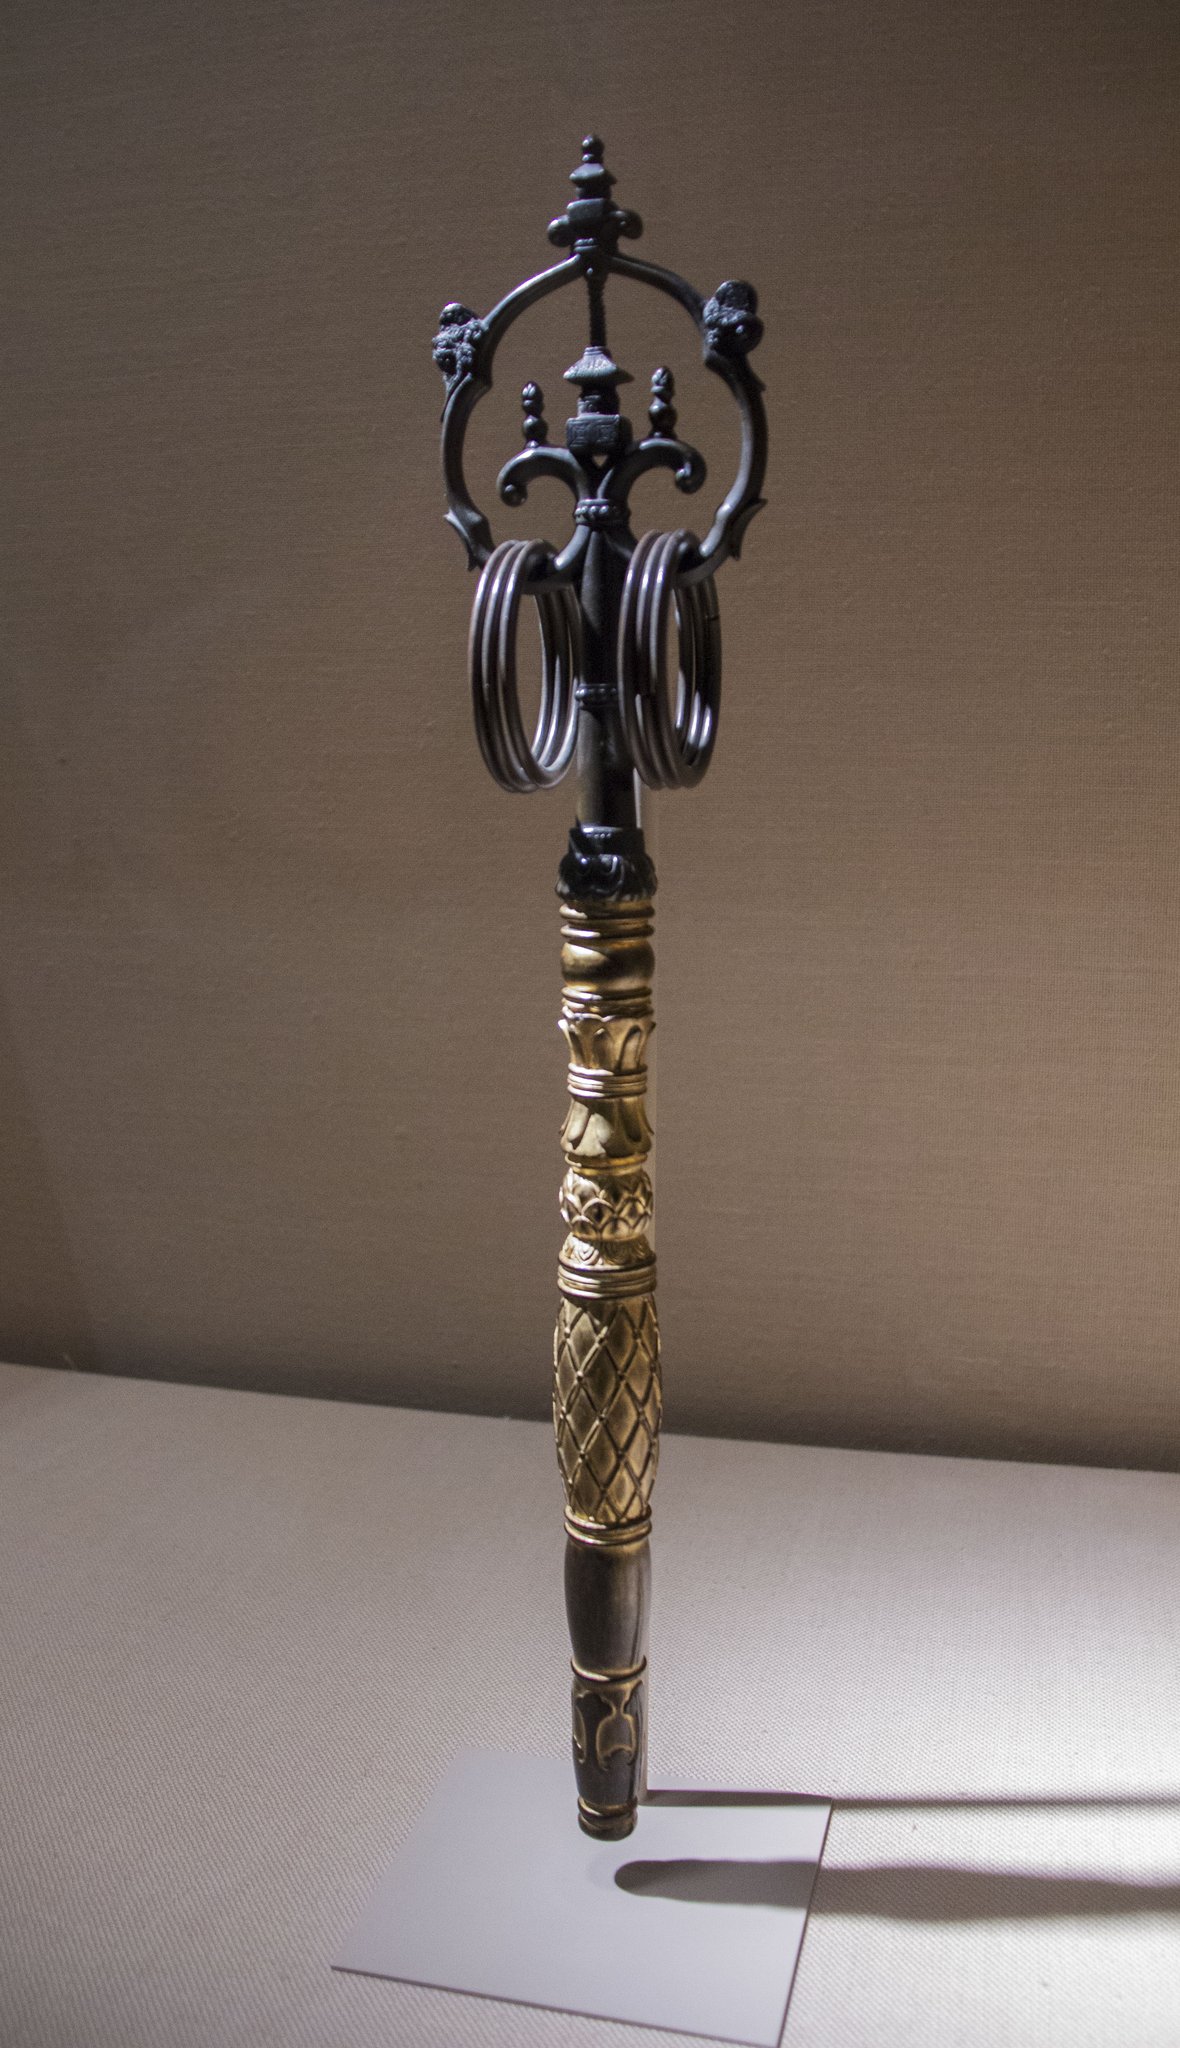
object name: staff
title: Ritual Staff (Shakujō)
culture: japanese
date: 1801-1833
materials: bronze, cord, silk, wood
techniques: lacquer